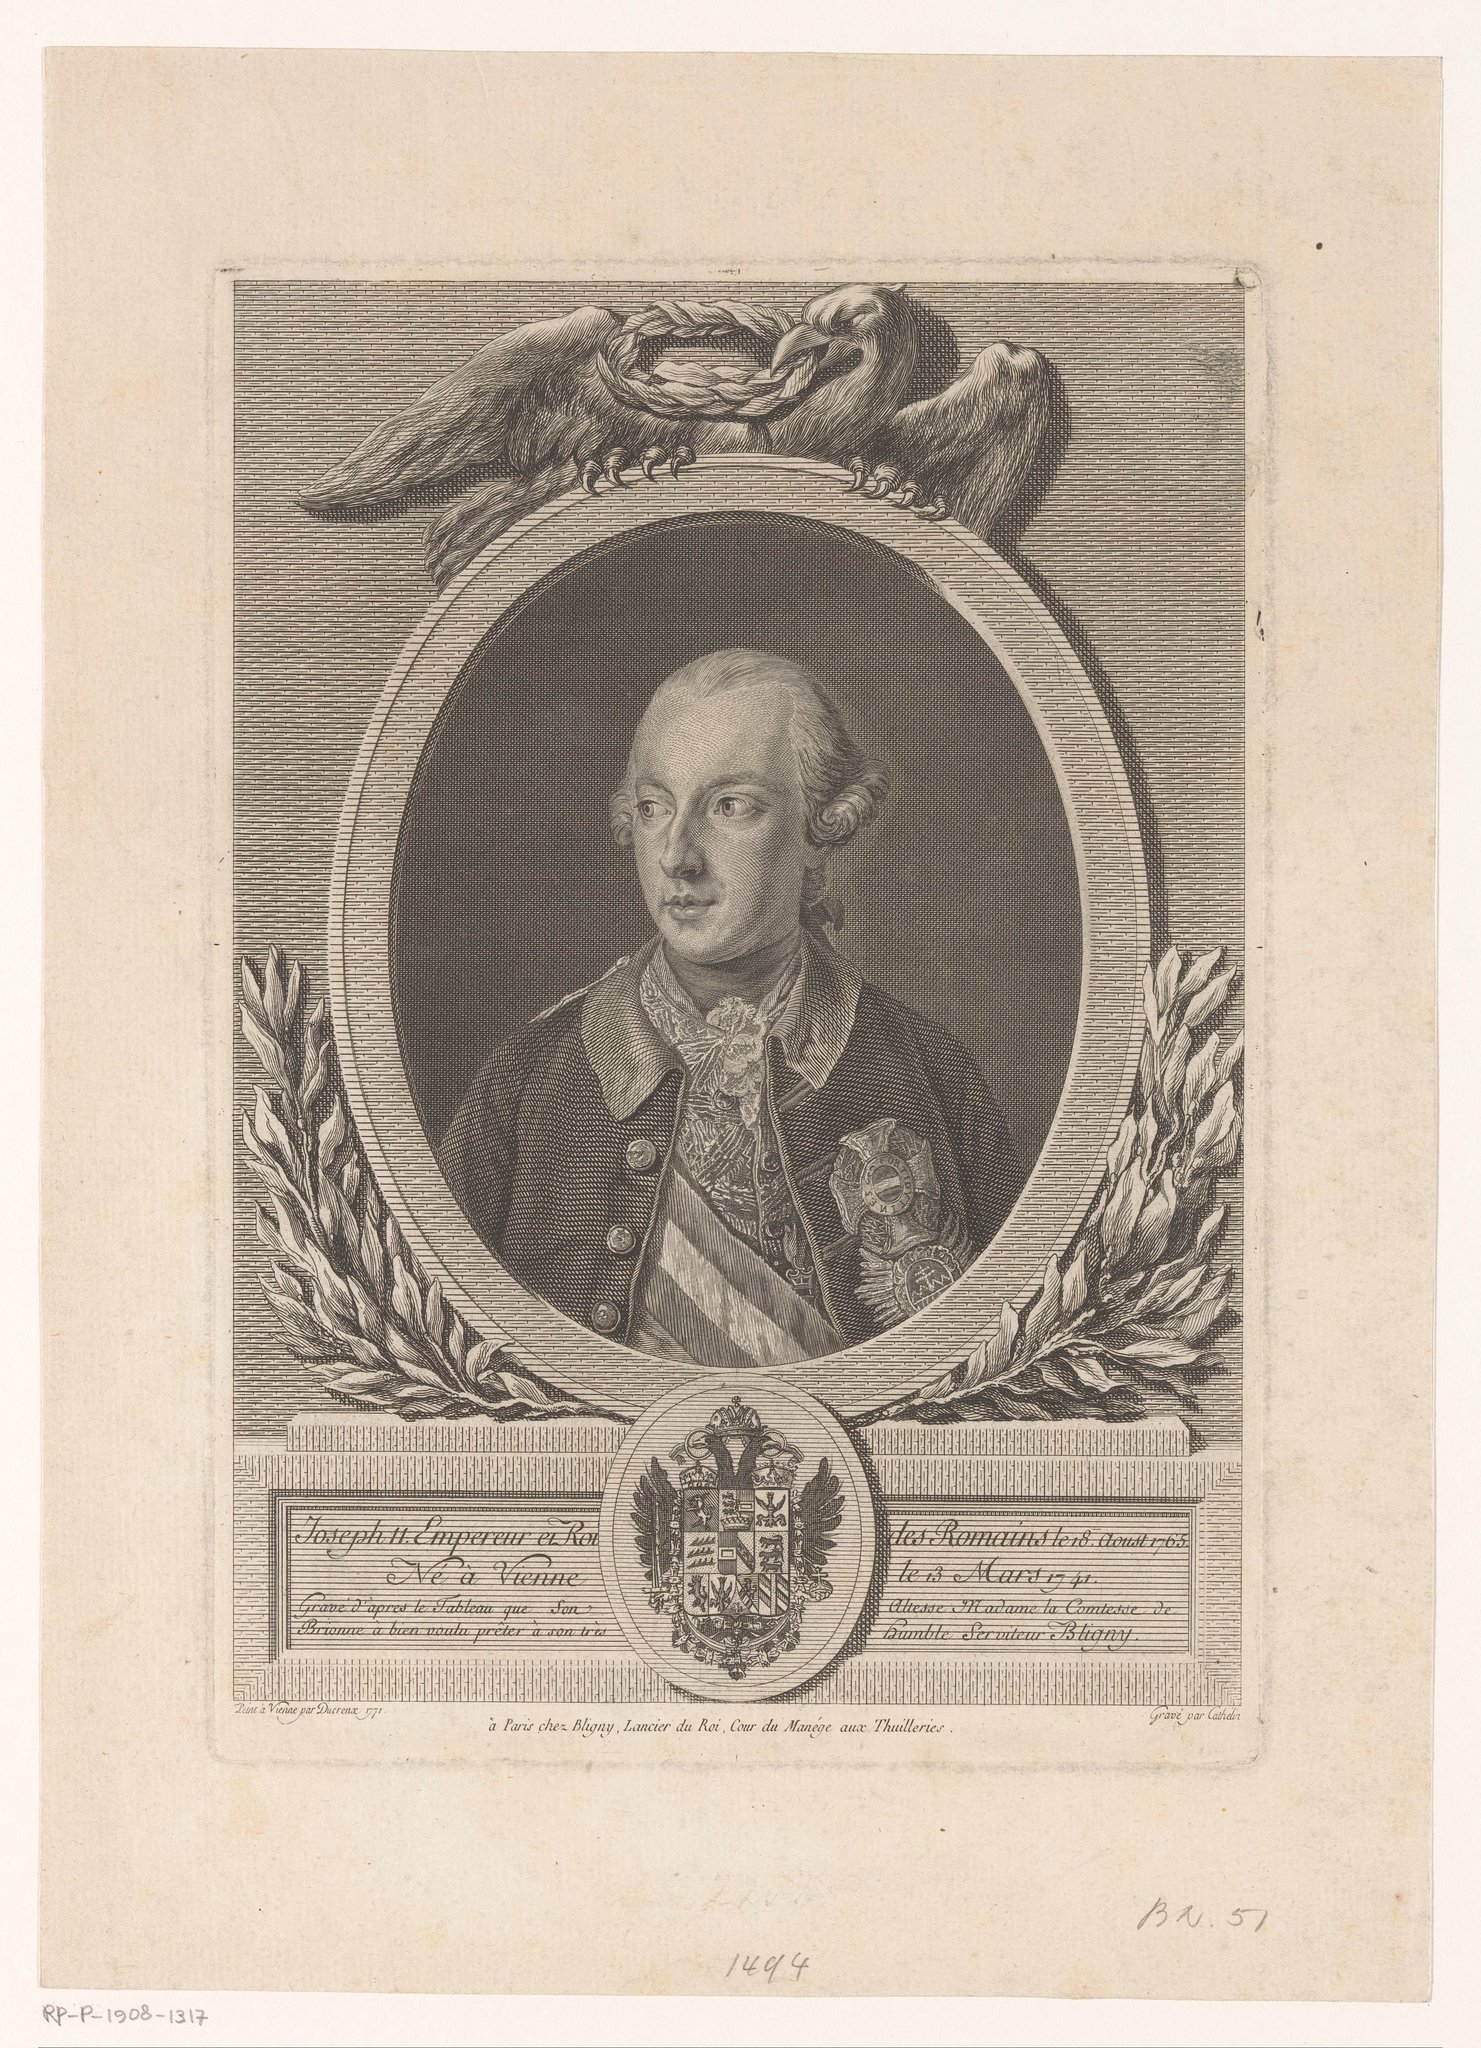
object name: print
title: Portret van Jozef II in een ovale lijst met een adelaar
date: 1771-1804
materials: paper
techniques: engraving, etching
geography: france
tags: jozef ii (duits keizer), predatory birds: eagle, historical persons, emperor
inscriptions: collector's mark: Lugt 2228